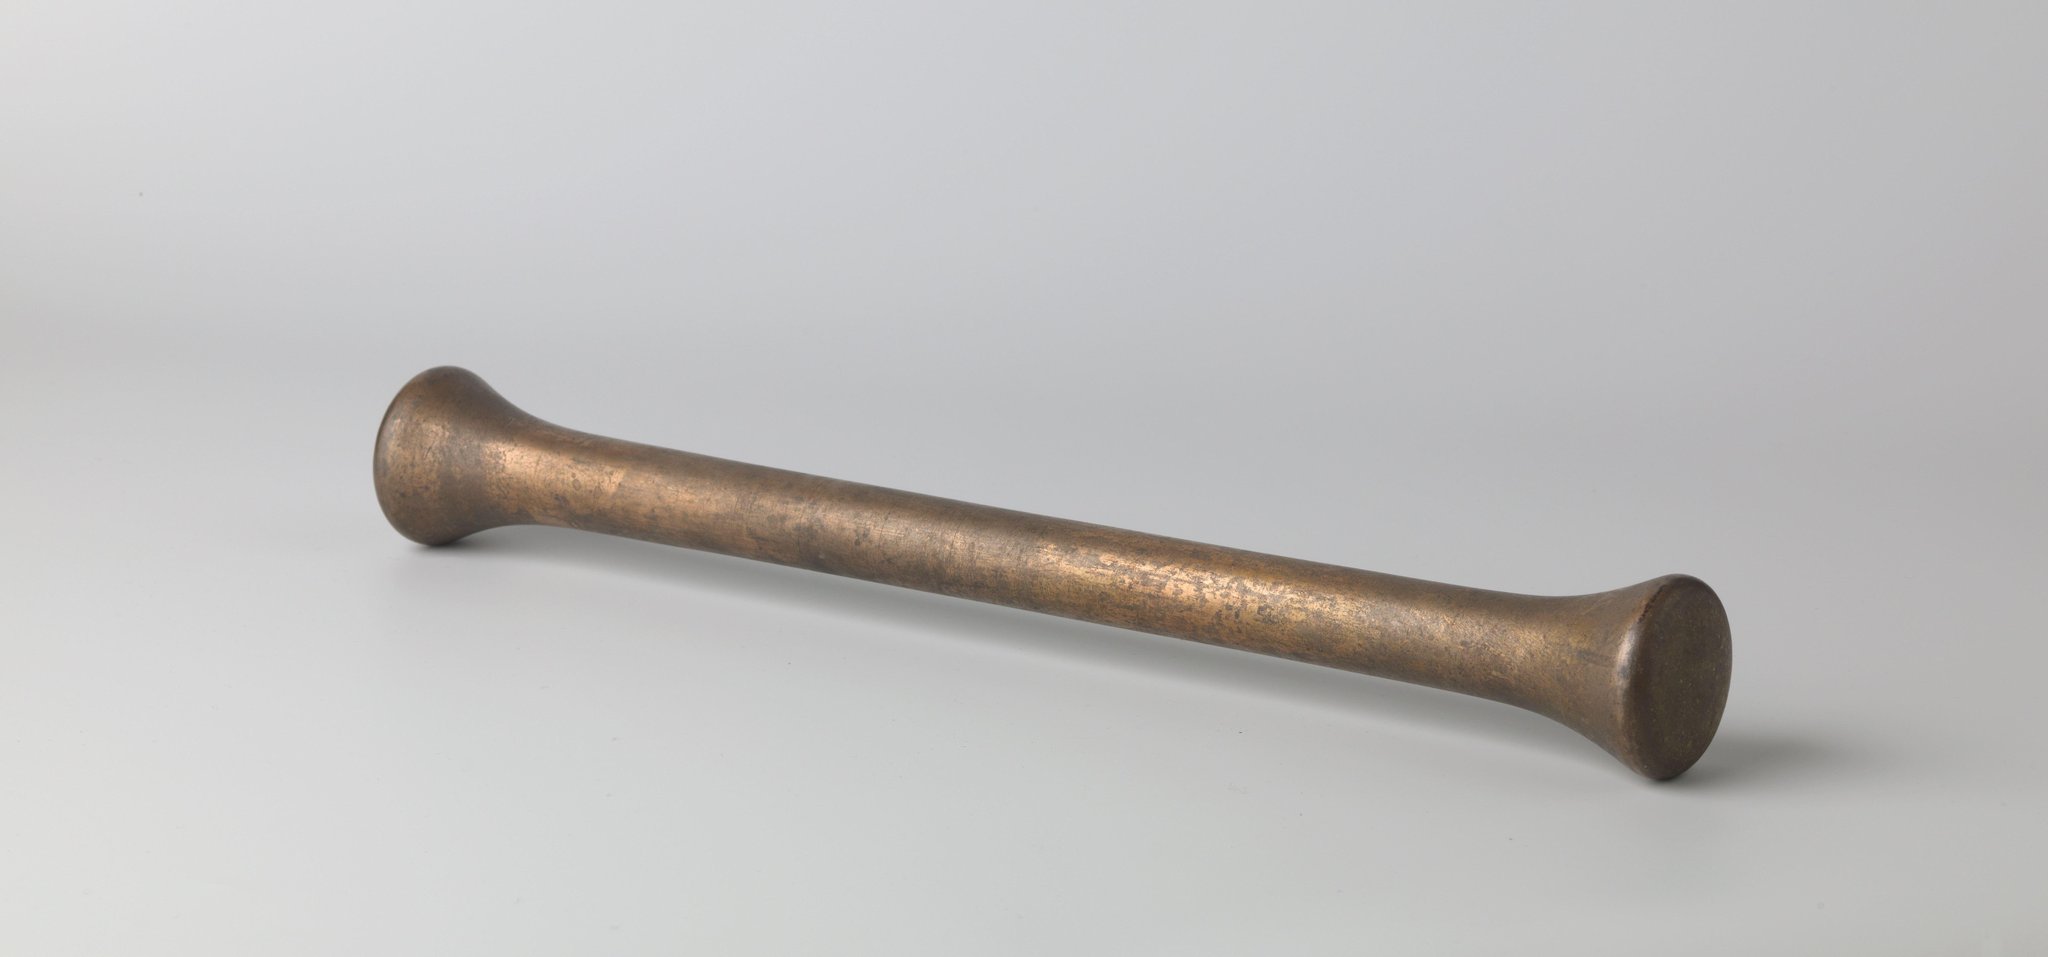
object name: beater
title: Stamper van brons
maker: Anonymous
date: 1700-1800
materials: bronze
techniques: casting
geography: netherlands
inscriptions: inscription: ‘2’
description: Stamper van gegoten brons. Deze wordt naar de einden toe iets breder.